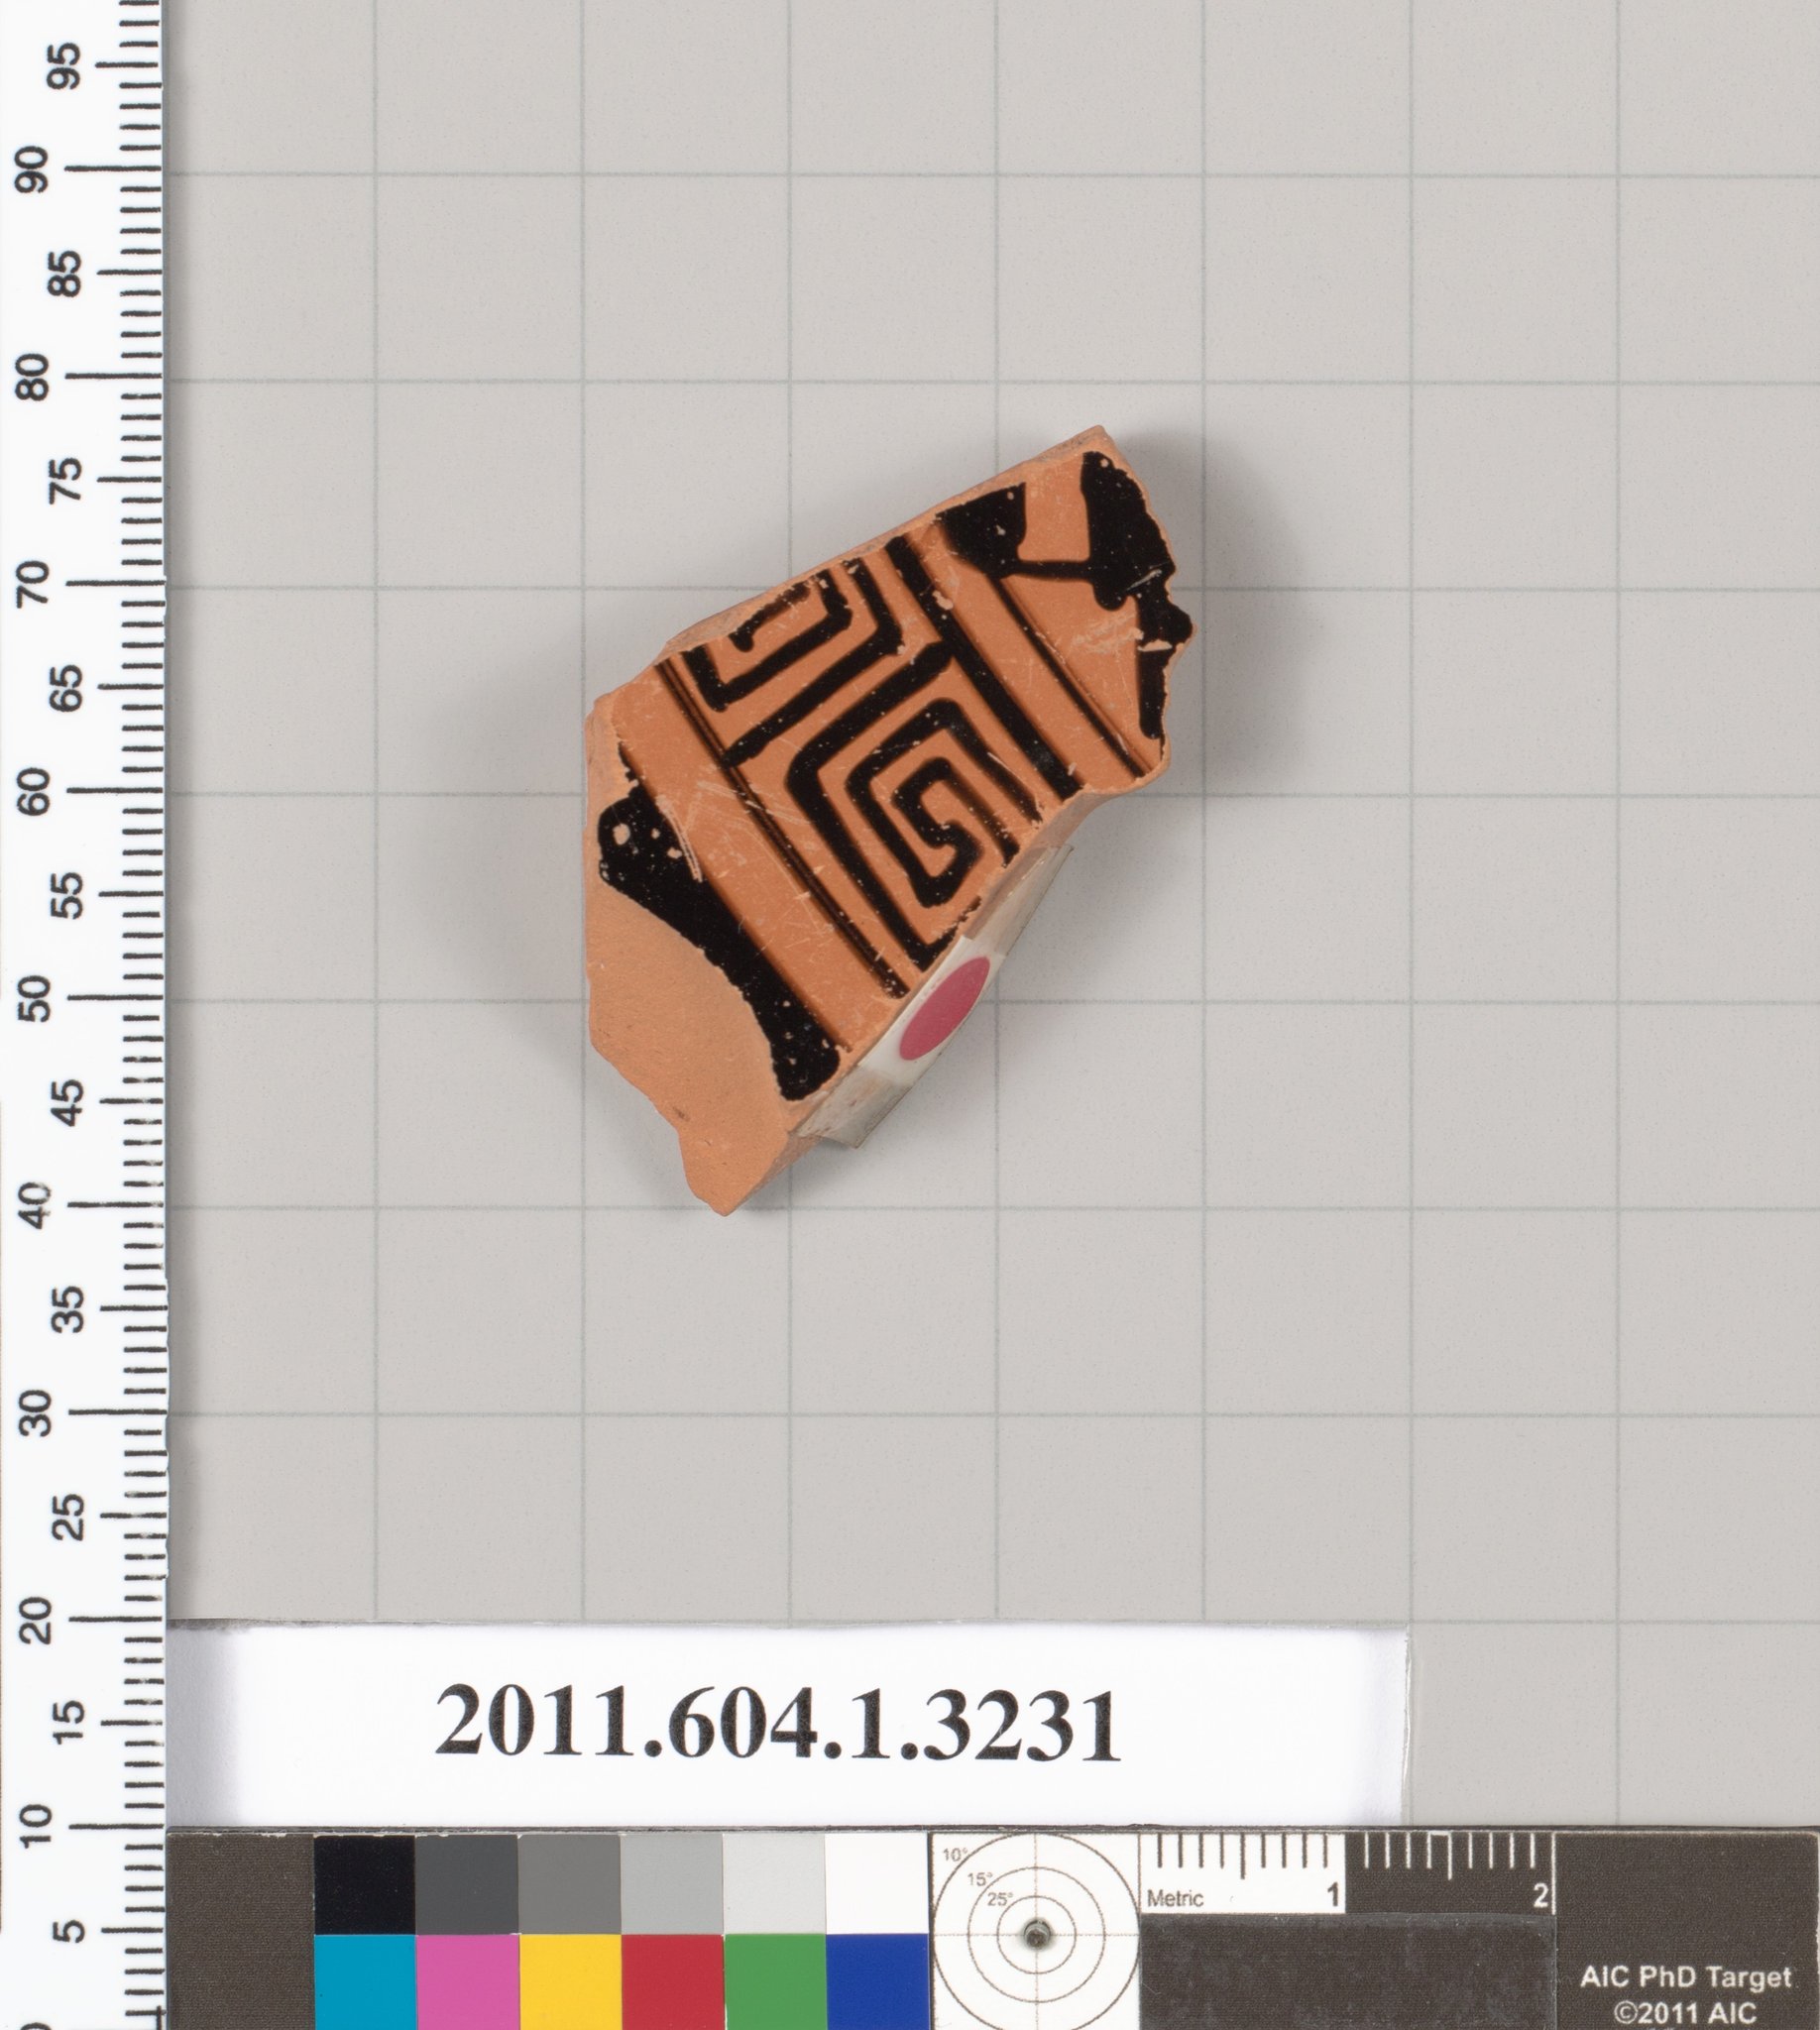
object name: kylix fragment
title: Terracotta fragment of a kylix (drinking cup)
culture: greek, attic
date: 460-450 BCE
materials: terracotta